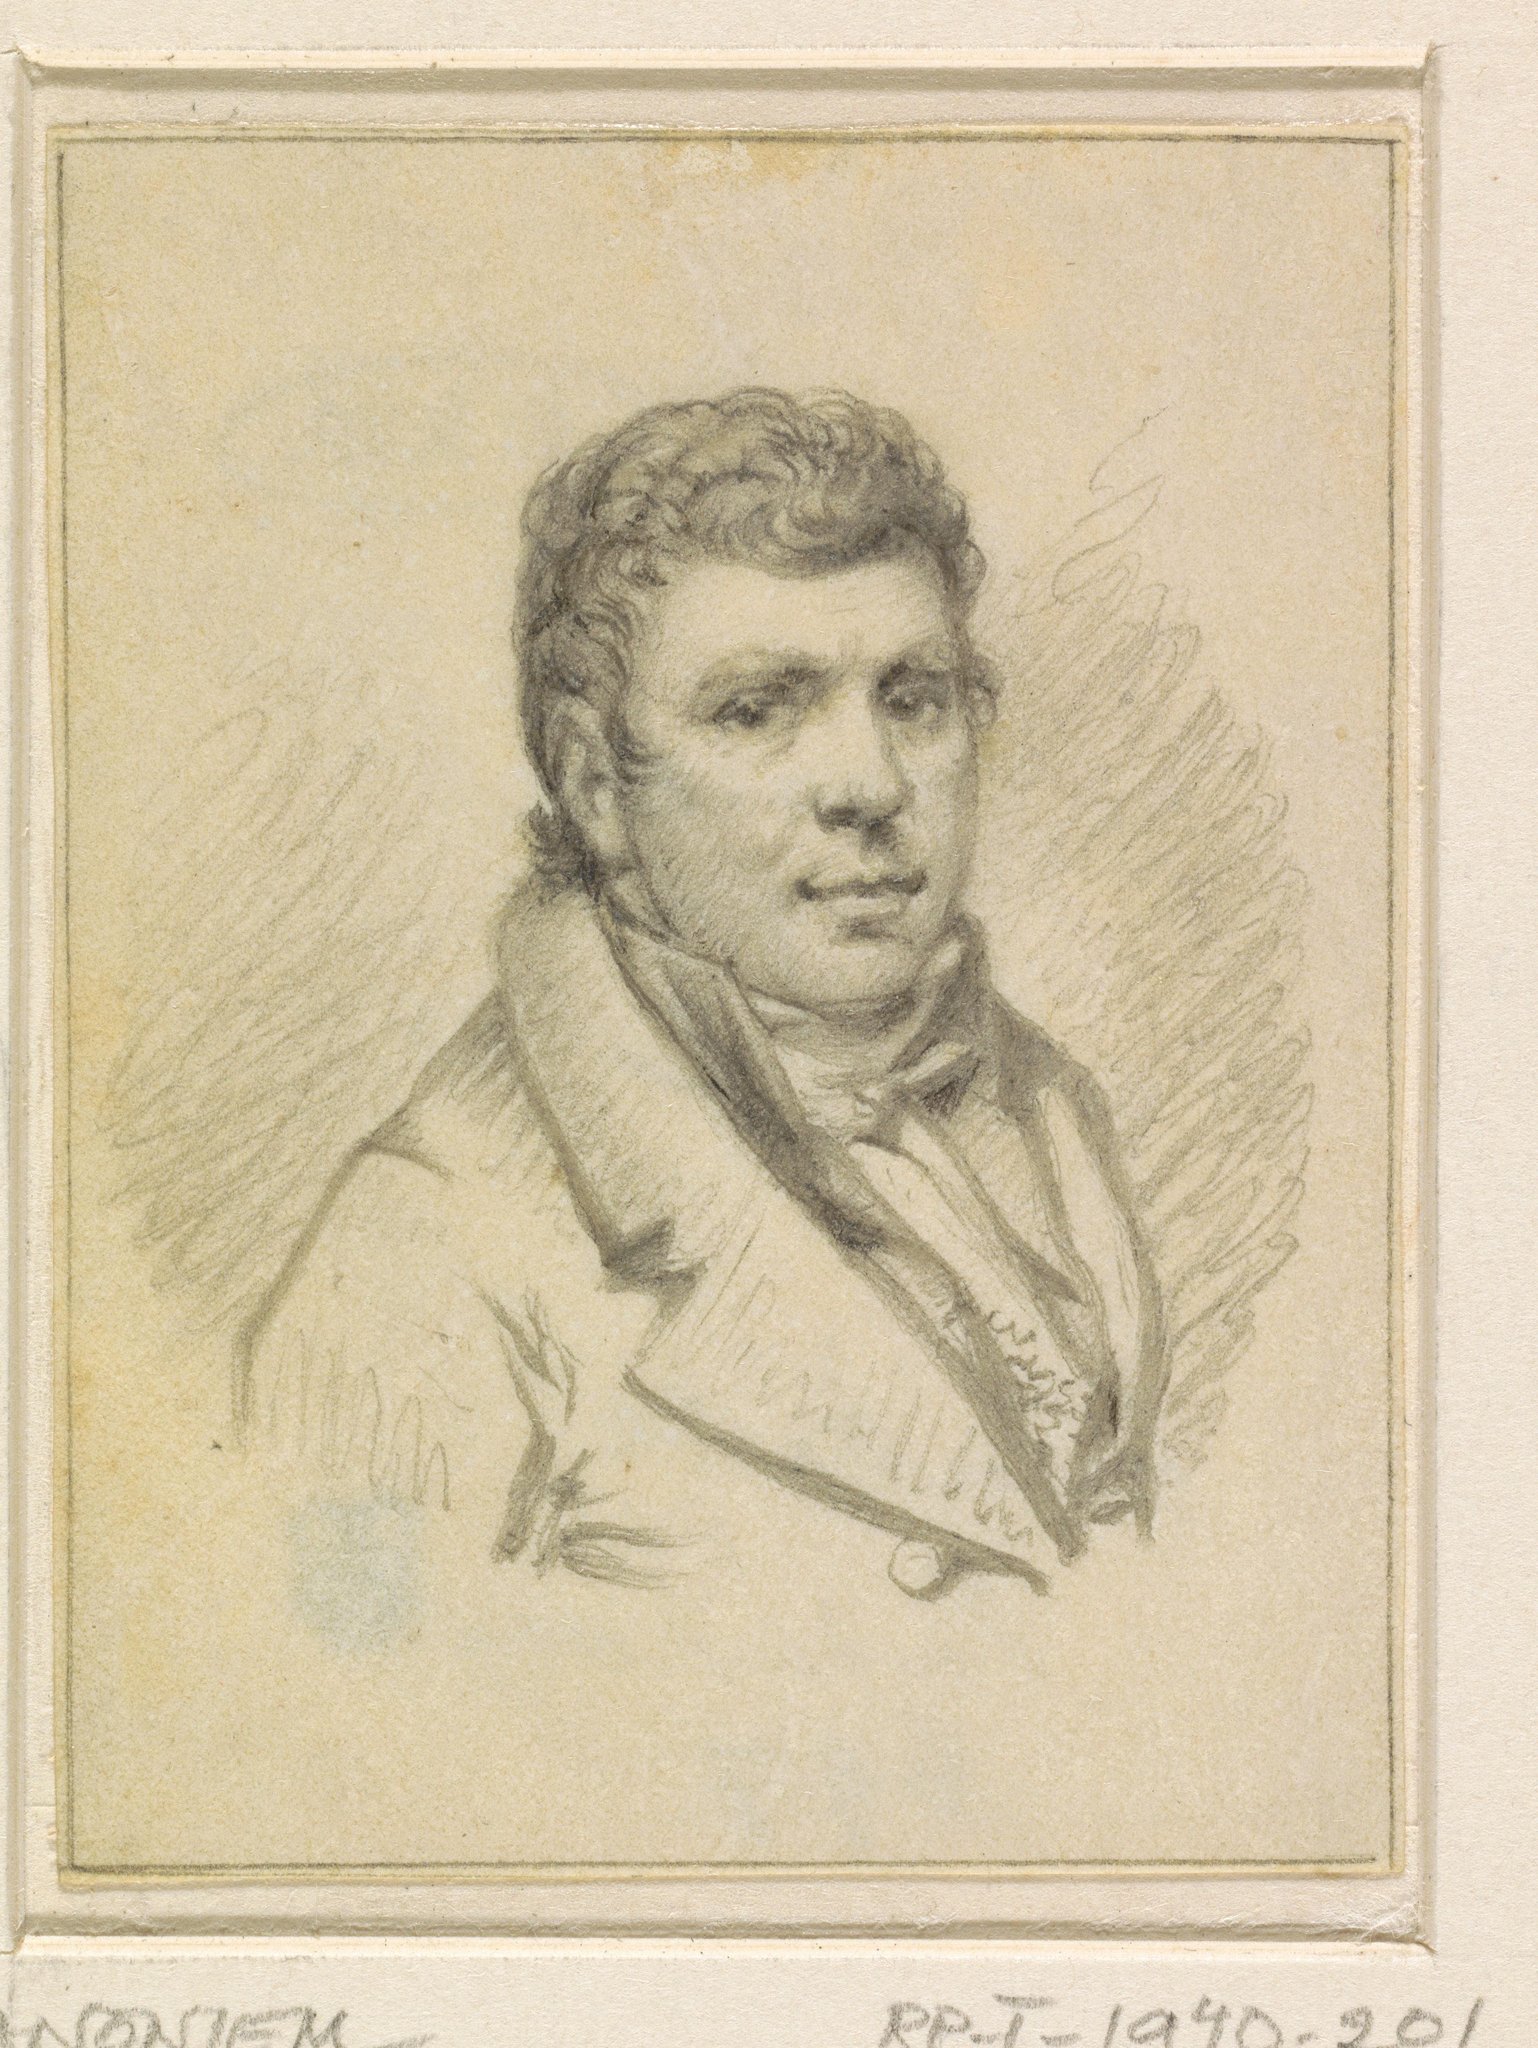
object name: drawing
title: Portret van Willem Bartel van der Kooi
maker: Anonymous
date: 1778-1886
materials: parchment, pencil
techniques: brush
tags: draughtsman, willem bartel van der kooi, historical persons, portrait, self-portrait of artist